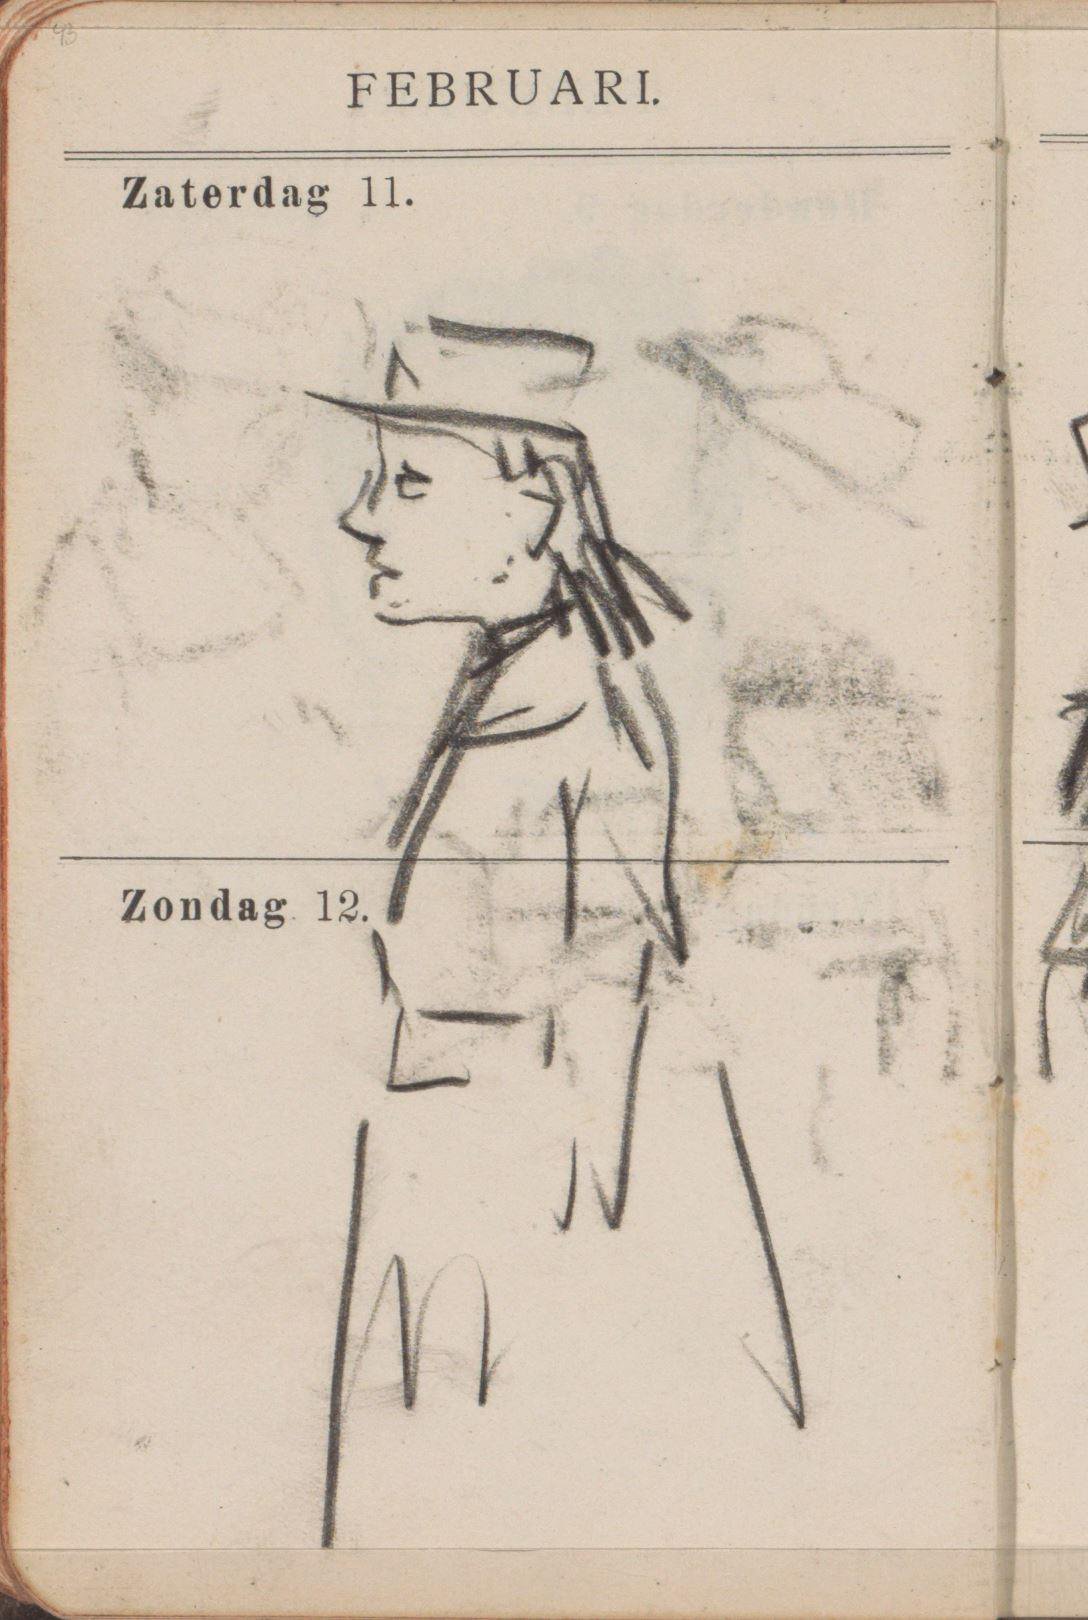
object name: sketchbook leaf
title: Staande vrouw met hoed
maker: george hendrik breitner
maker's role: draughtsman, painter, print maker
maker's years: 1857-1923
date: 1893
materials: chalk, paper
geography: amsterdam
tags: adult woman, standing figure - aa - female human figure (+ sideview, profile)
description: In profiel naar links. Pagina 43 uit een als schetsboek gebruikte agenda met 108 bladen.